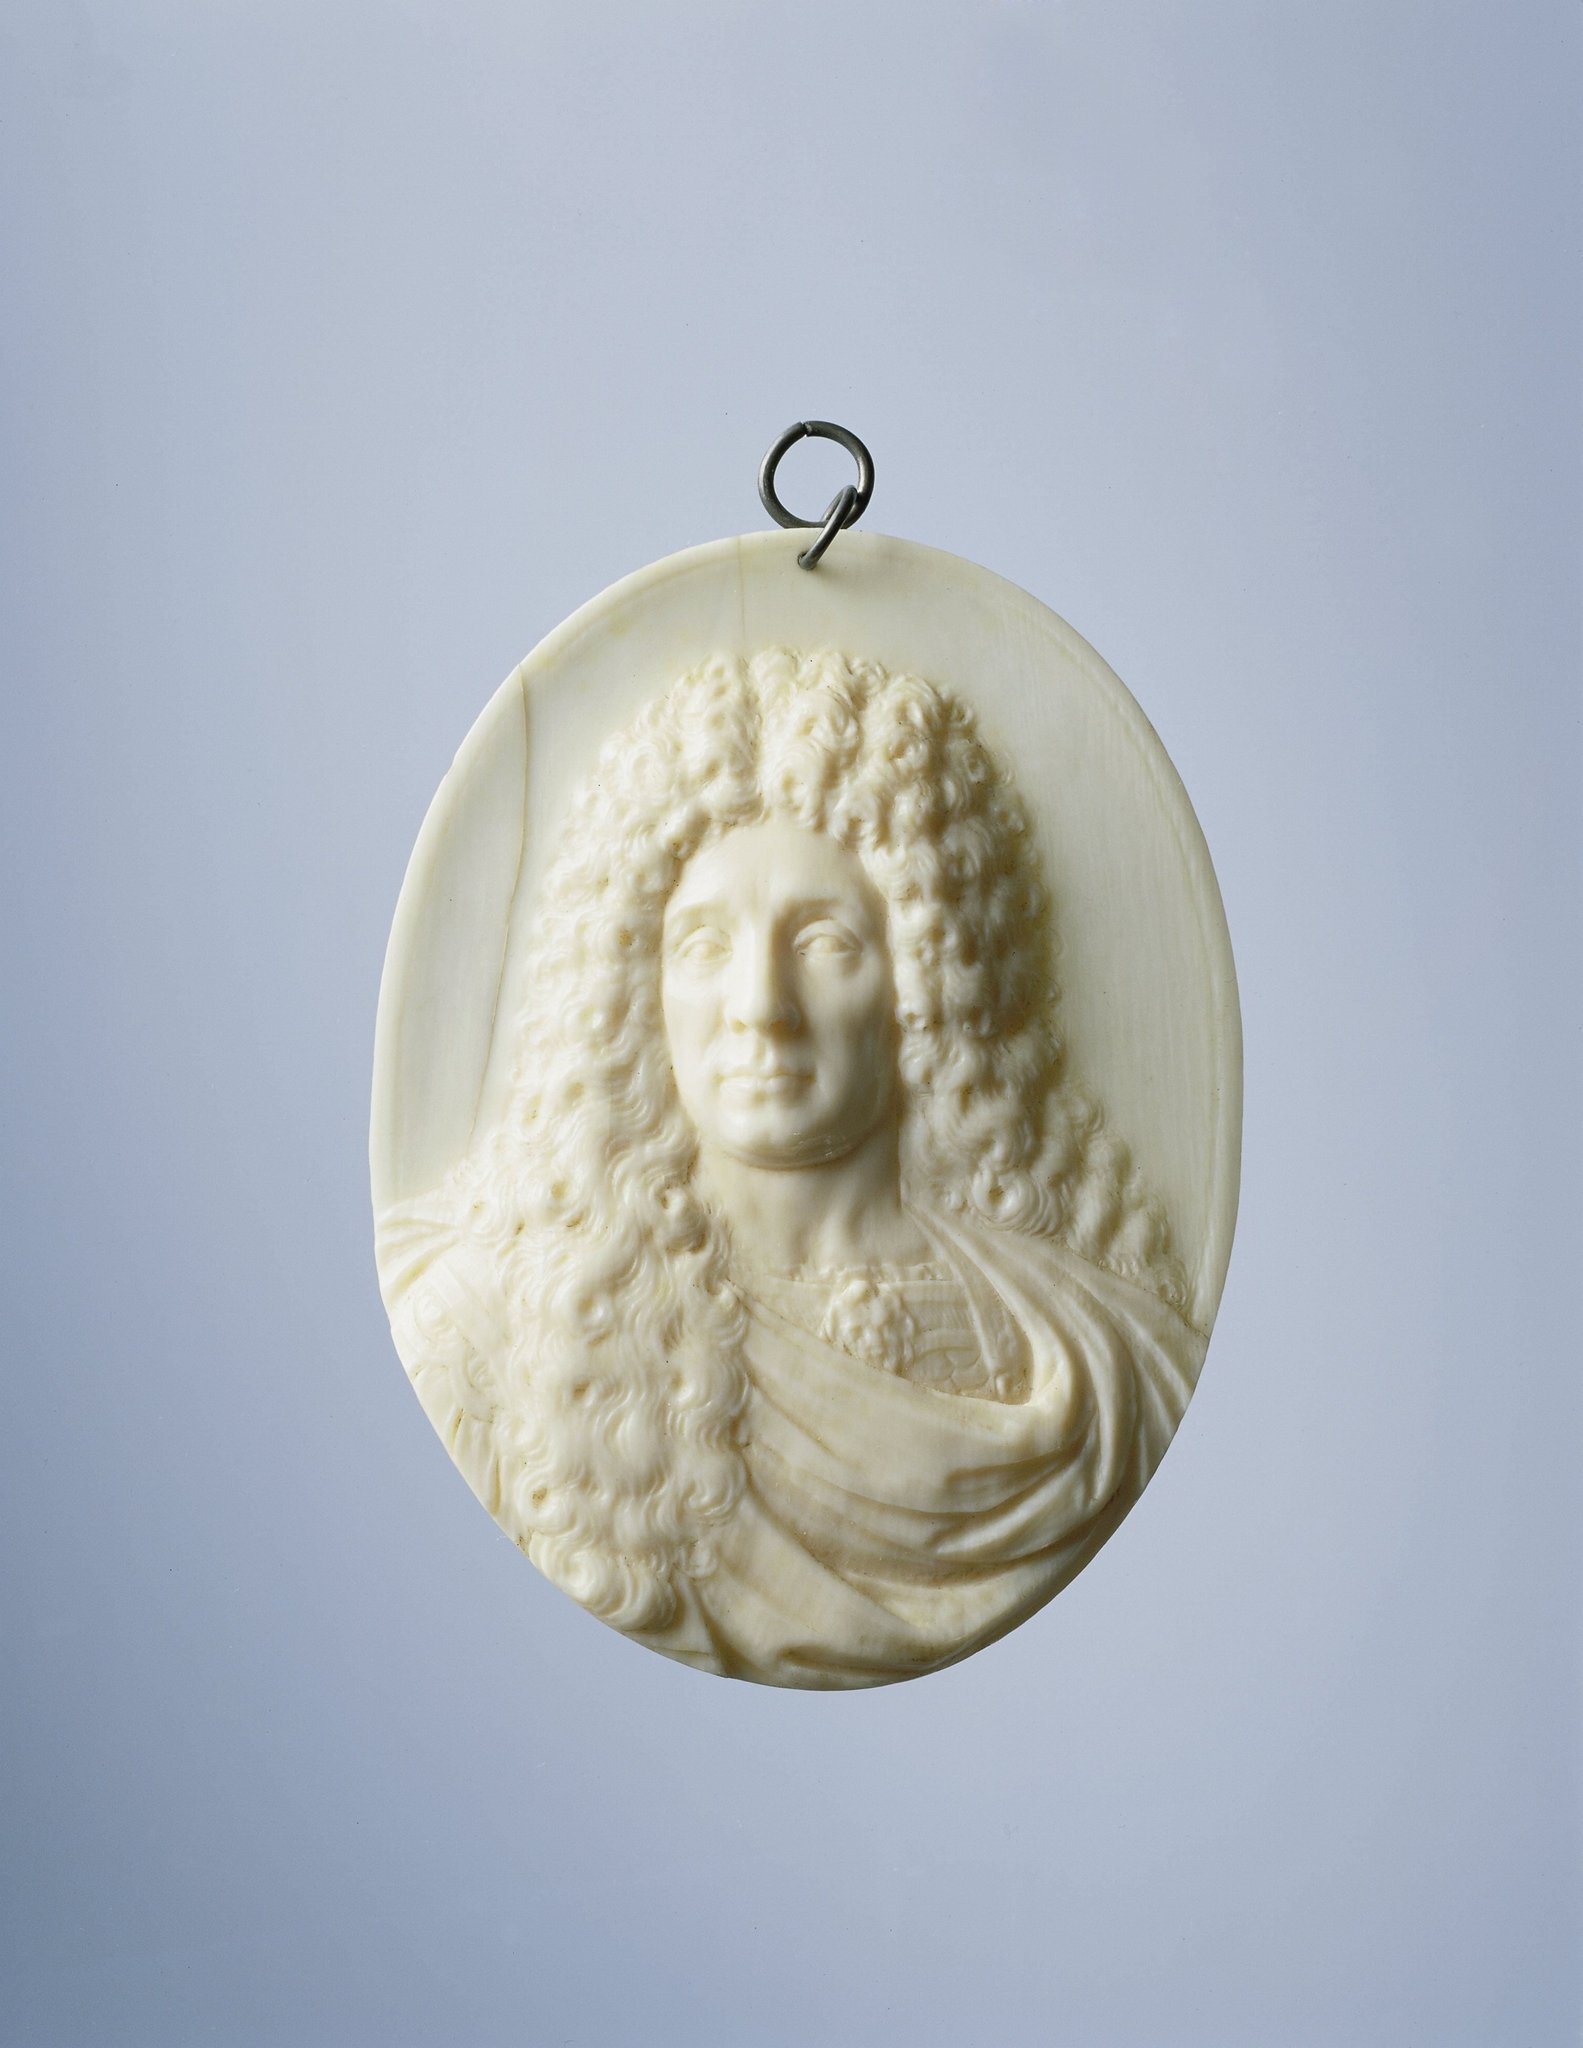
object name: locket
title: Medaillonportret van een heer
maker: Anonymous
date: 1700-1725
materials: ivory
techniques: cutting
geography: france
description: Het lichaam is driekwart naar rechts gewend, het hoofd even naar links. De man draagt een lange allongepruik, waarvan een deel afhangt voor de rechter schouder, waarop de mantel samenkomt. Deze ligt gedrapeerd over het pseudo-Romeinse harnas, dat bij de hals een geplooid hemd en een masker vertoond, alsmede van de schouder afhangende repen leer.